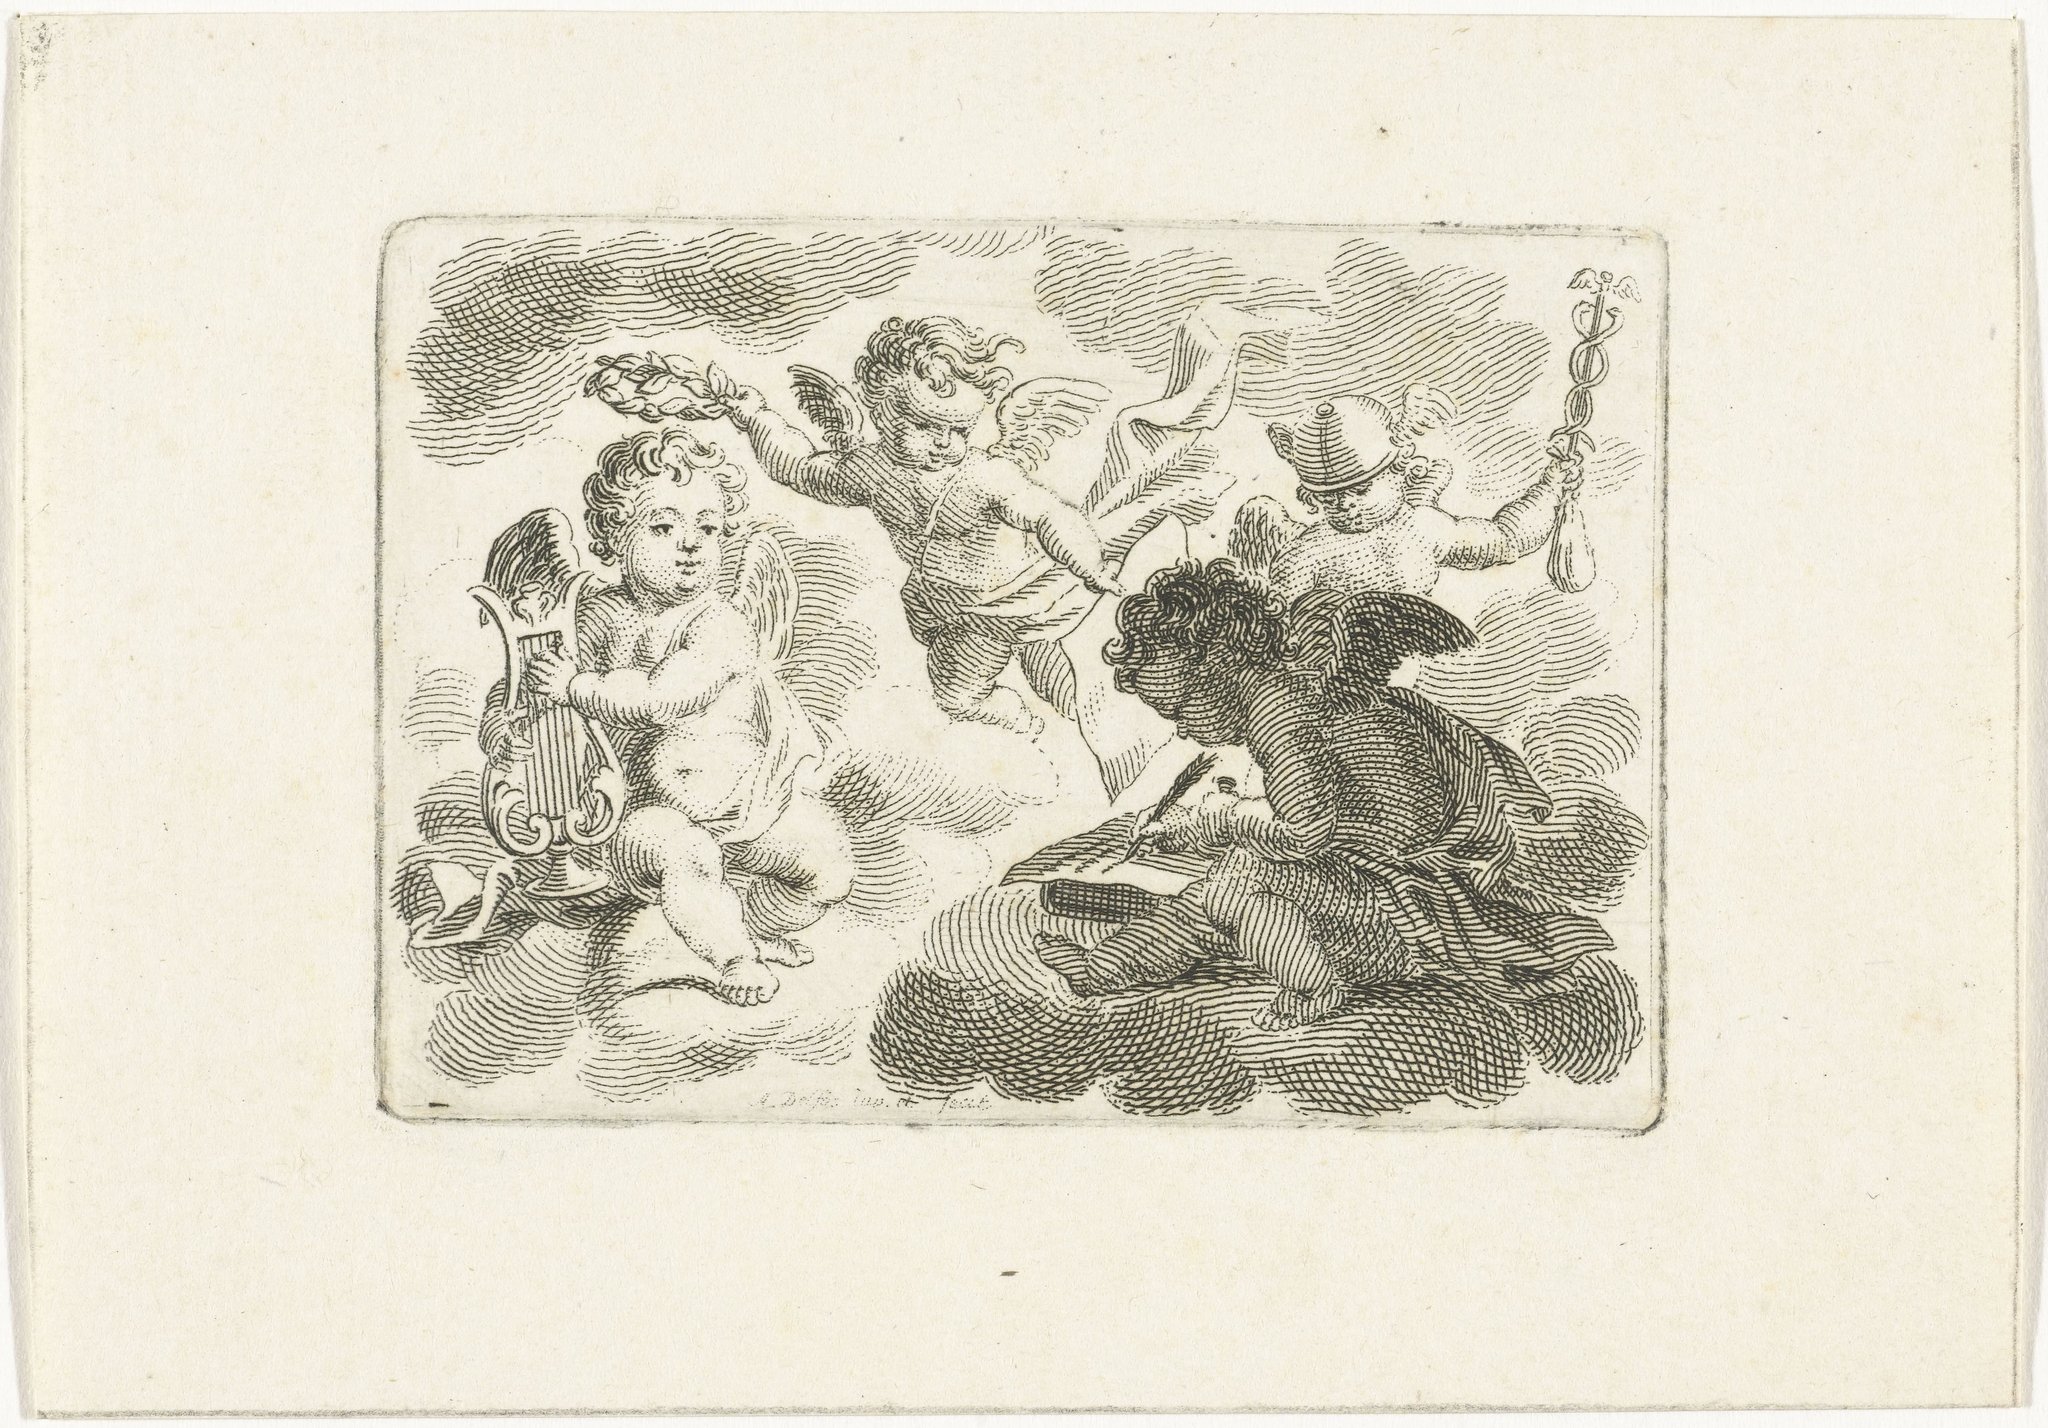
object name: print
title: Vier putti als personificaties van kunsten en wetenschappen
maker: abraham delfos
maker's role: draughtsman, painter, print maker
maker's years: 1731-1820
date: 1741-1820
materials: paper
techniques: etching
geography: leiden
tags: (story of) mercury (hermes), cupids: 'amores', 'amoretti', 'putti'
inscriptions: collector's mark: Lugt 240